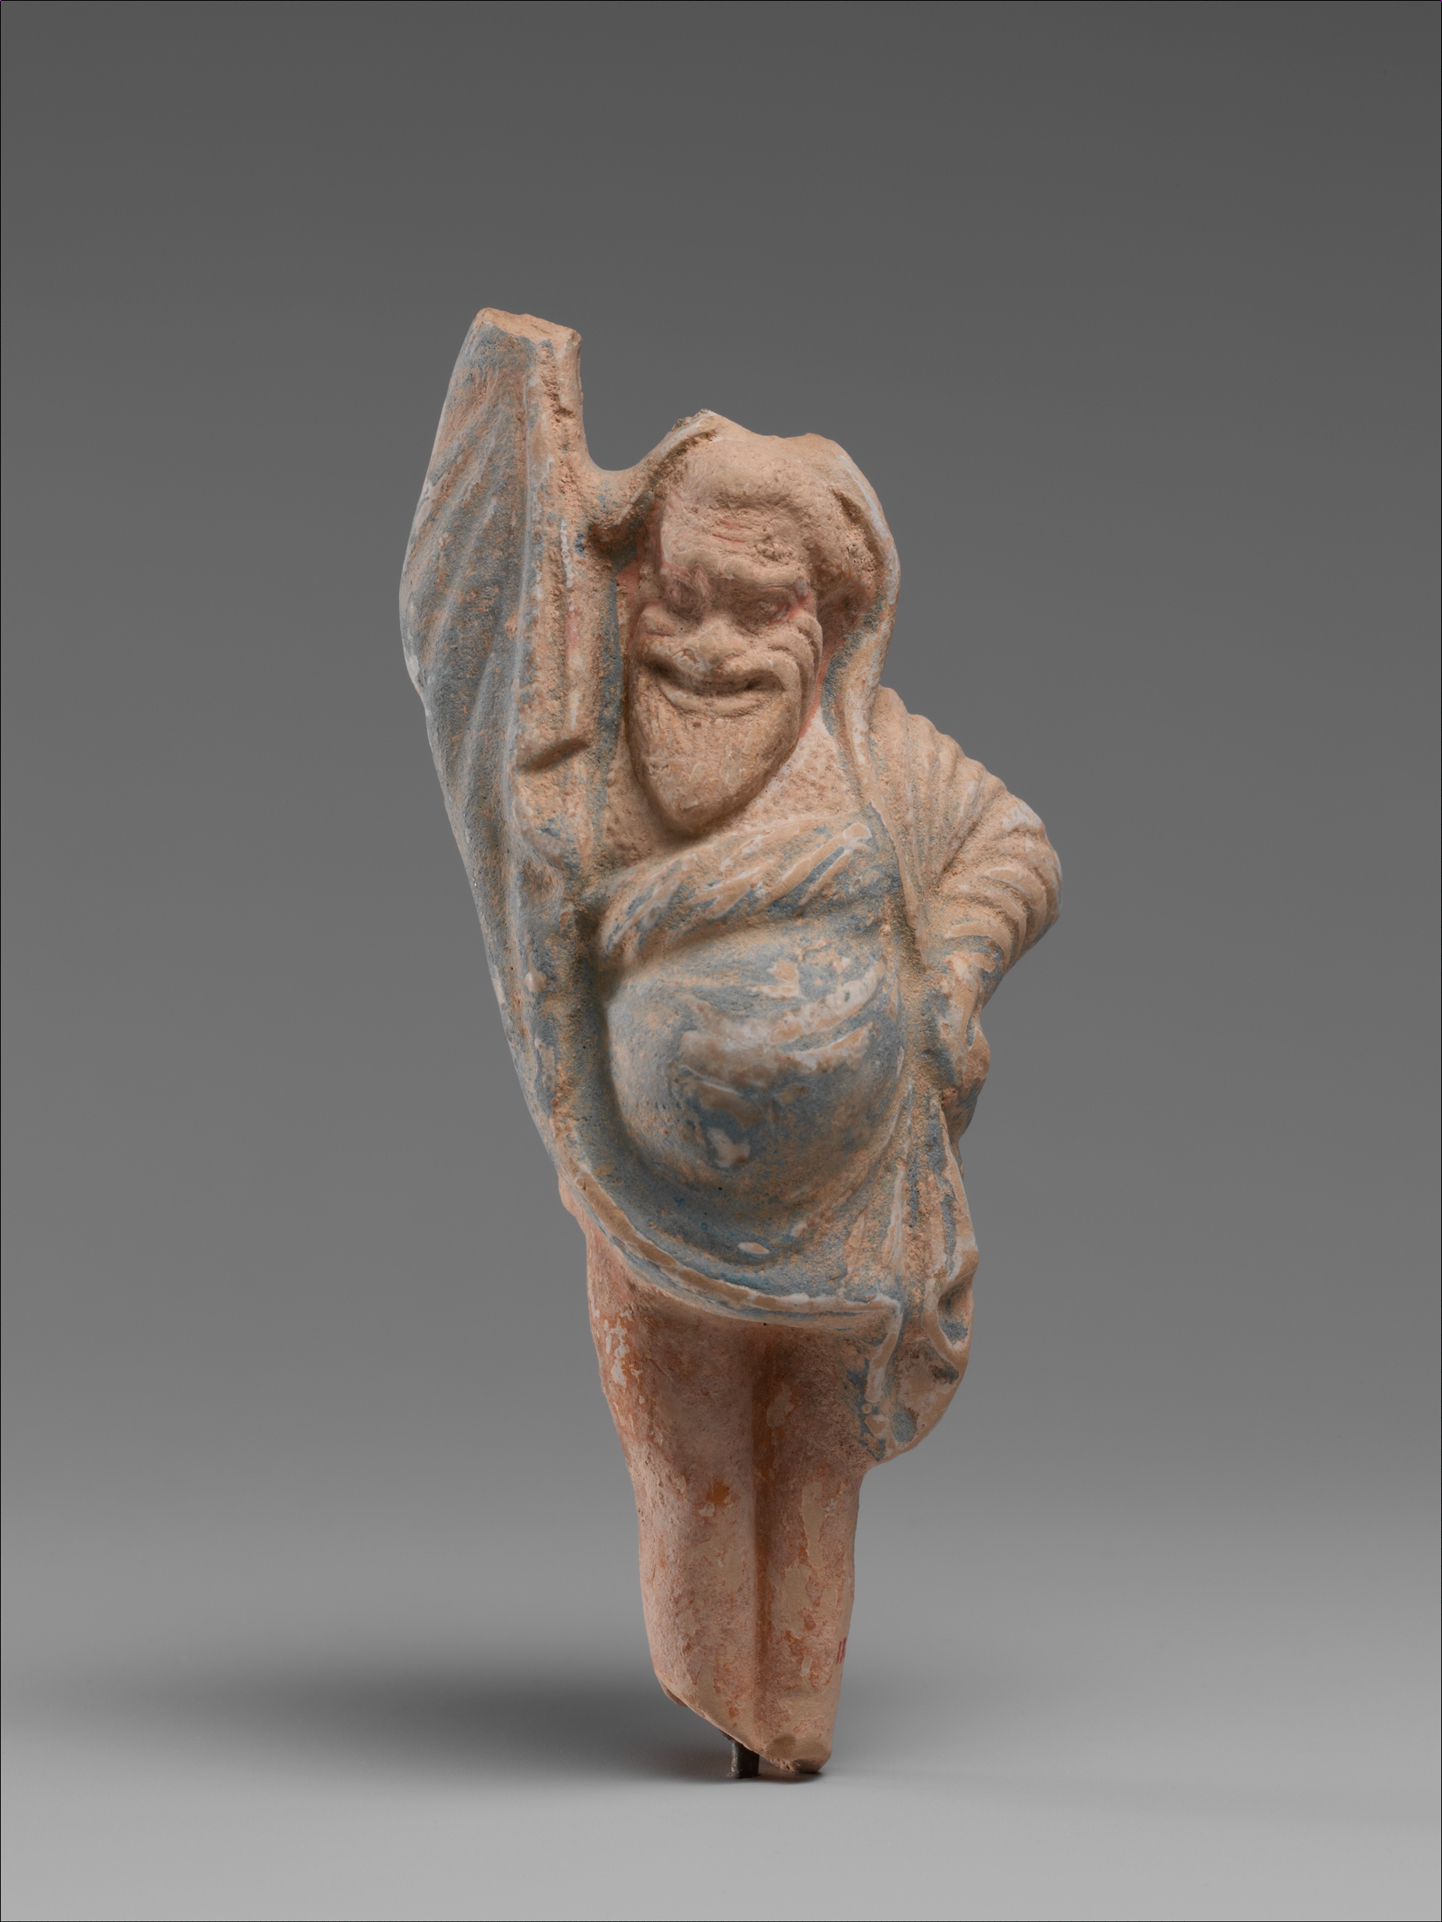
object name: statuette of an actor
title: Terracotta statuette of an actor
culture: greek, attic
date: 434-368 BCE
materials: terracotta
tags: men,actors